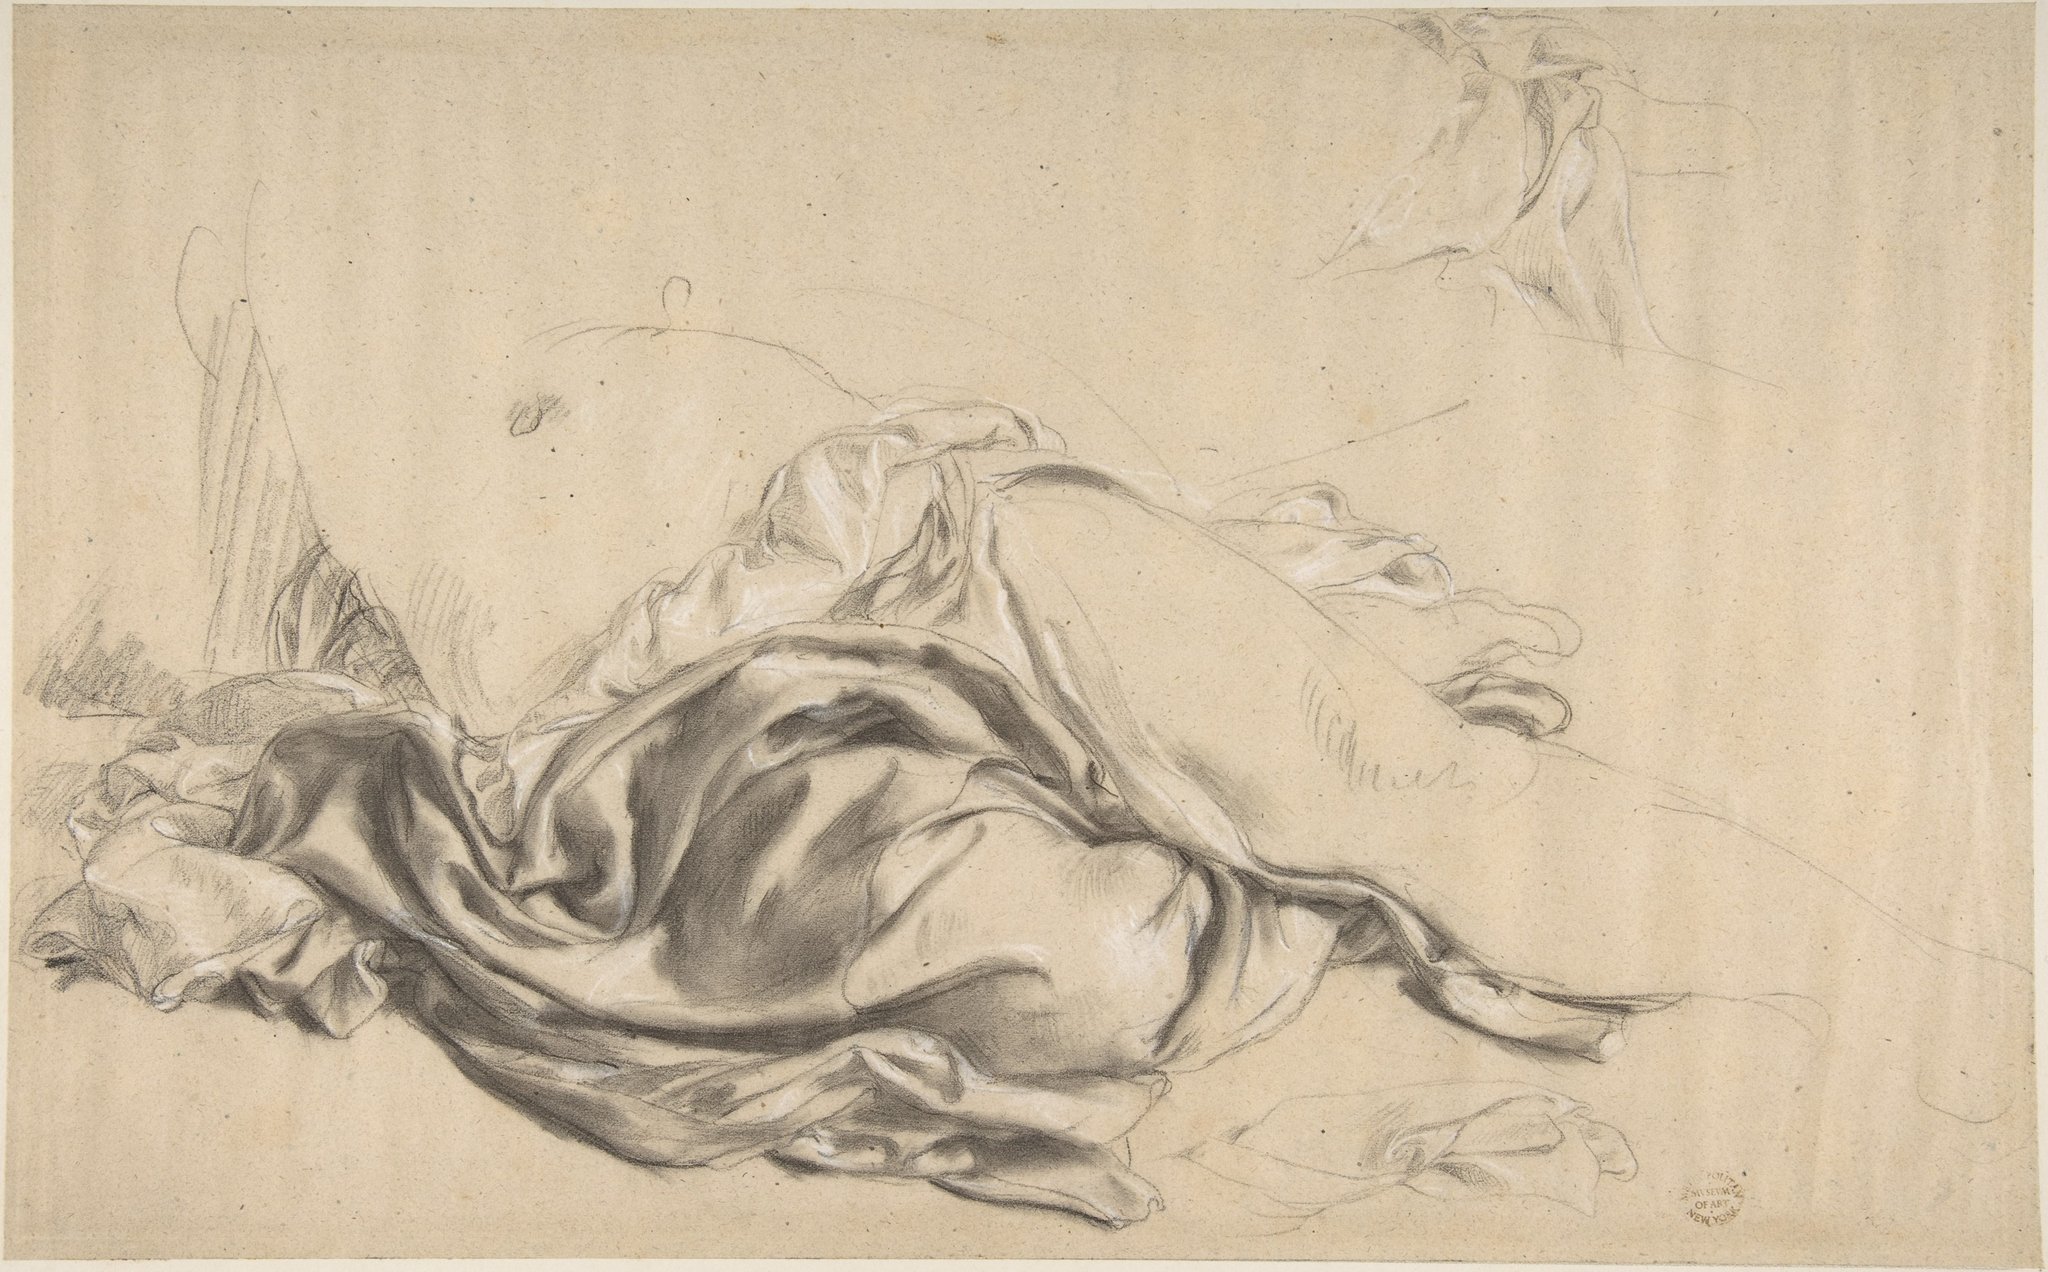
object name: drawing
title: Study in Draperies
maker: romain cazes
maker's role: artist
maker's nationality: french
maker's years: 1808-1881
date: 1828-1881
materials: chalk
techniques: highlighting